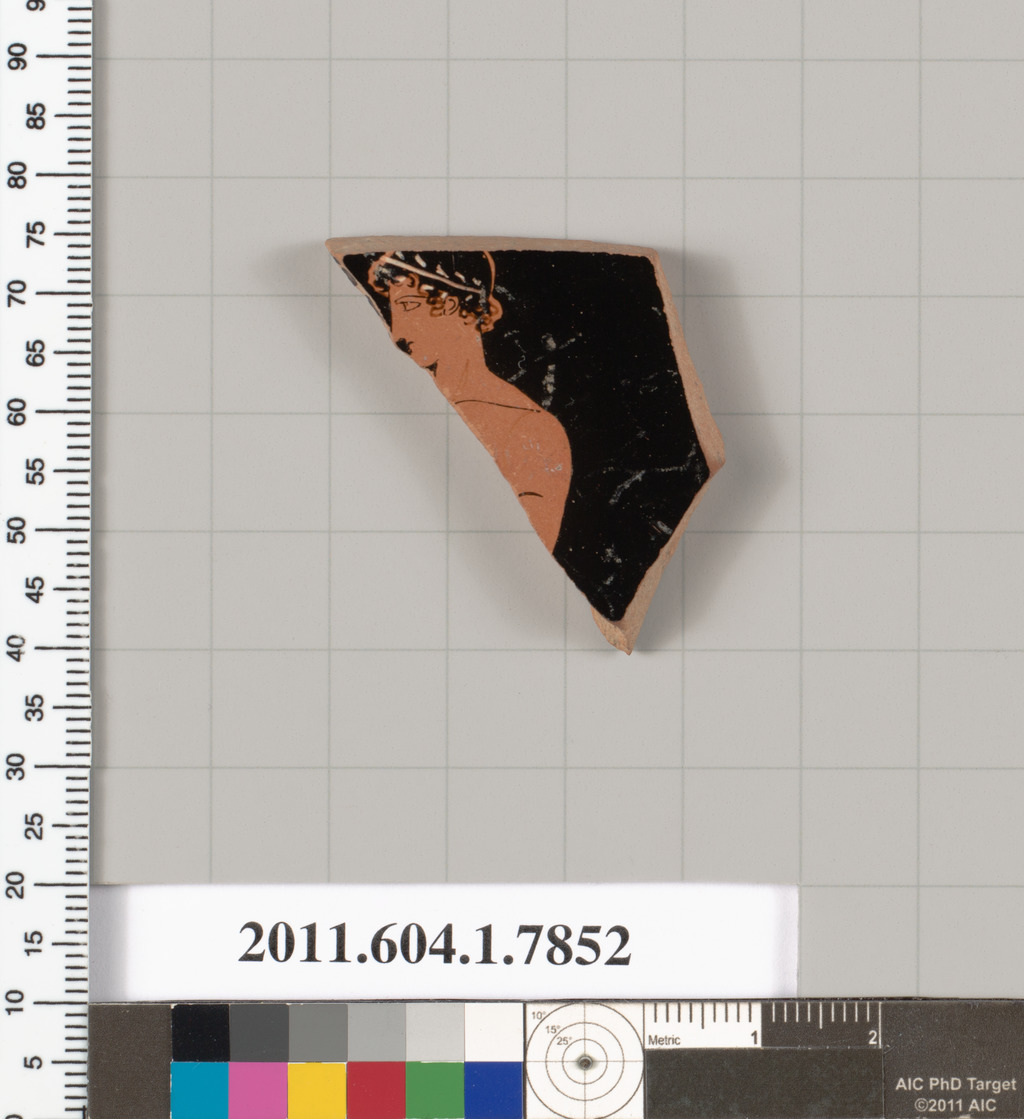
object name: kylix fragment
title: Terracotta fragment of a kylix (drinking cup)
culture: greek, attic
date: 440-420 BCE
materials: terracotta